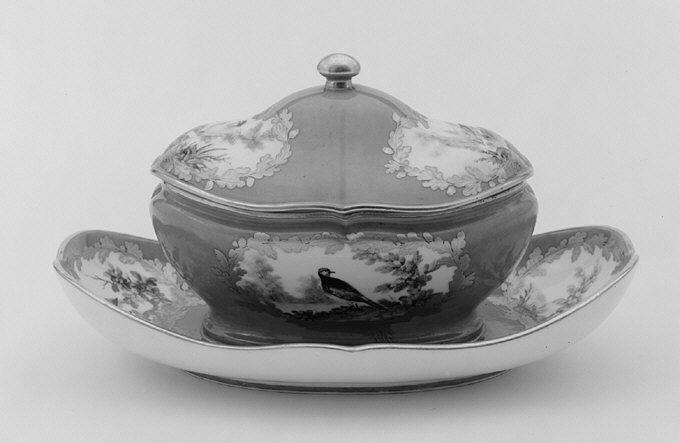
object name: sugar bowl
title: Sugar bowl with cover (sucrier de Monsieur le Premier) (one of a pair) (part of a service)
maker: sèvres manufactory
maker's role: manufactory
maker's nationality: french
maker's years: 1740-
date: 1772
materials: soft paste porcelain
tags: birds,trees